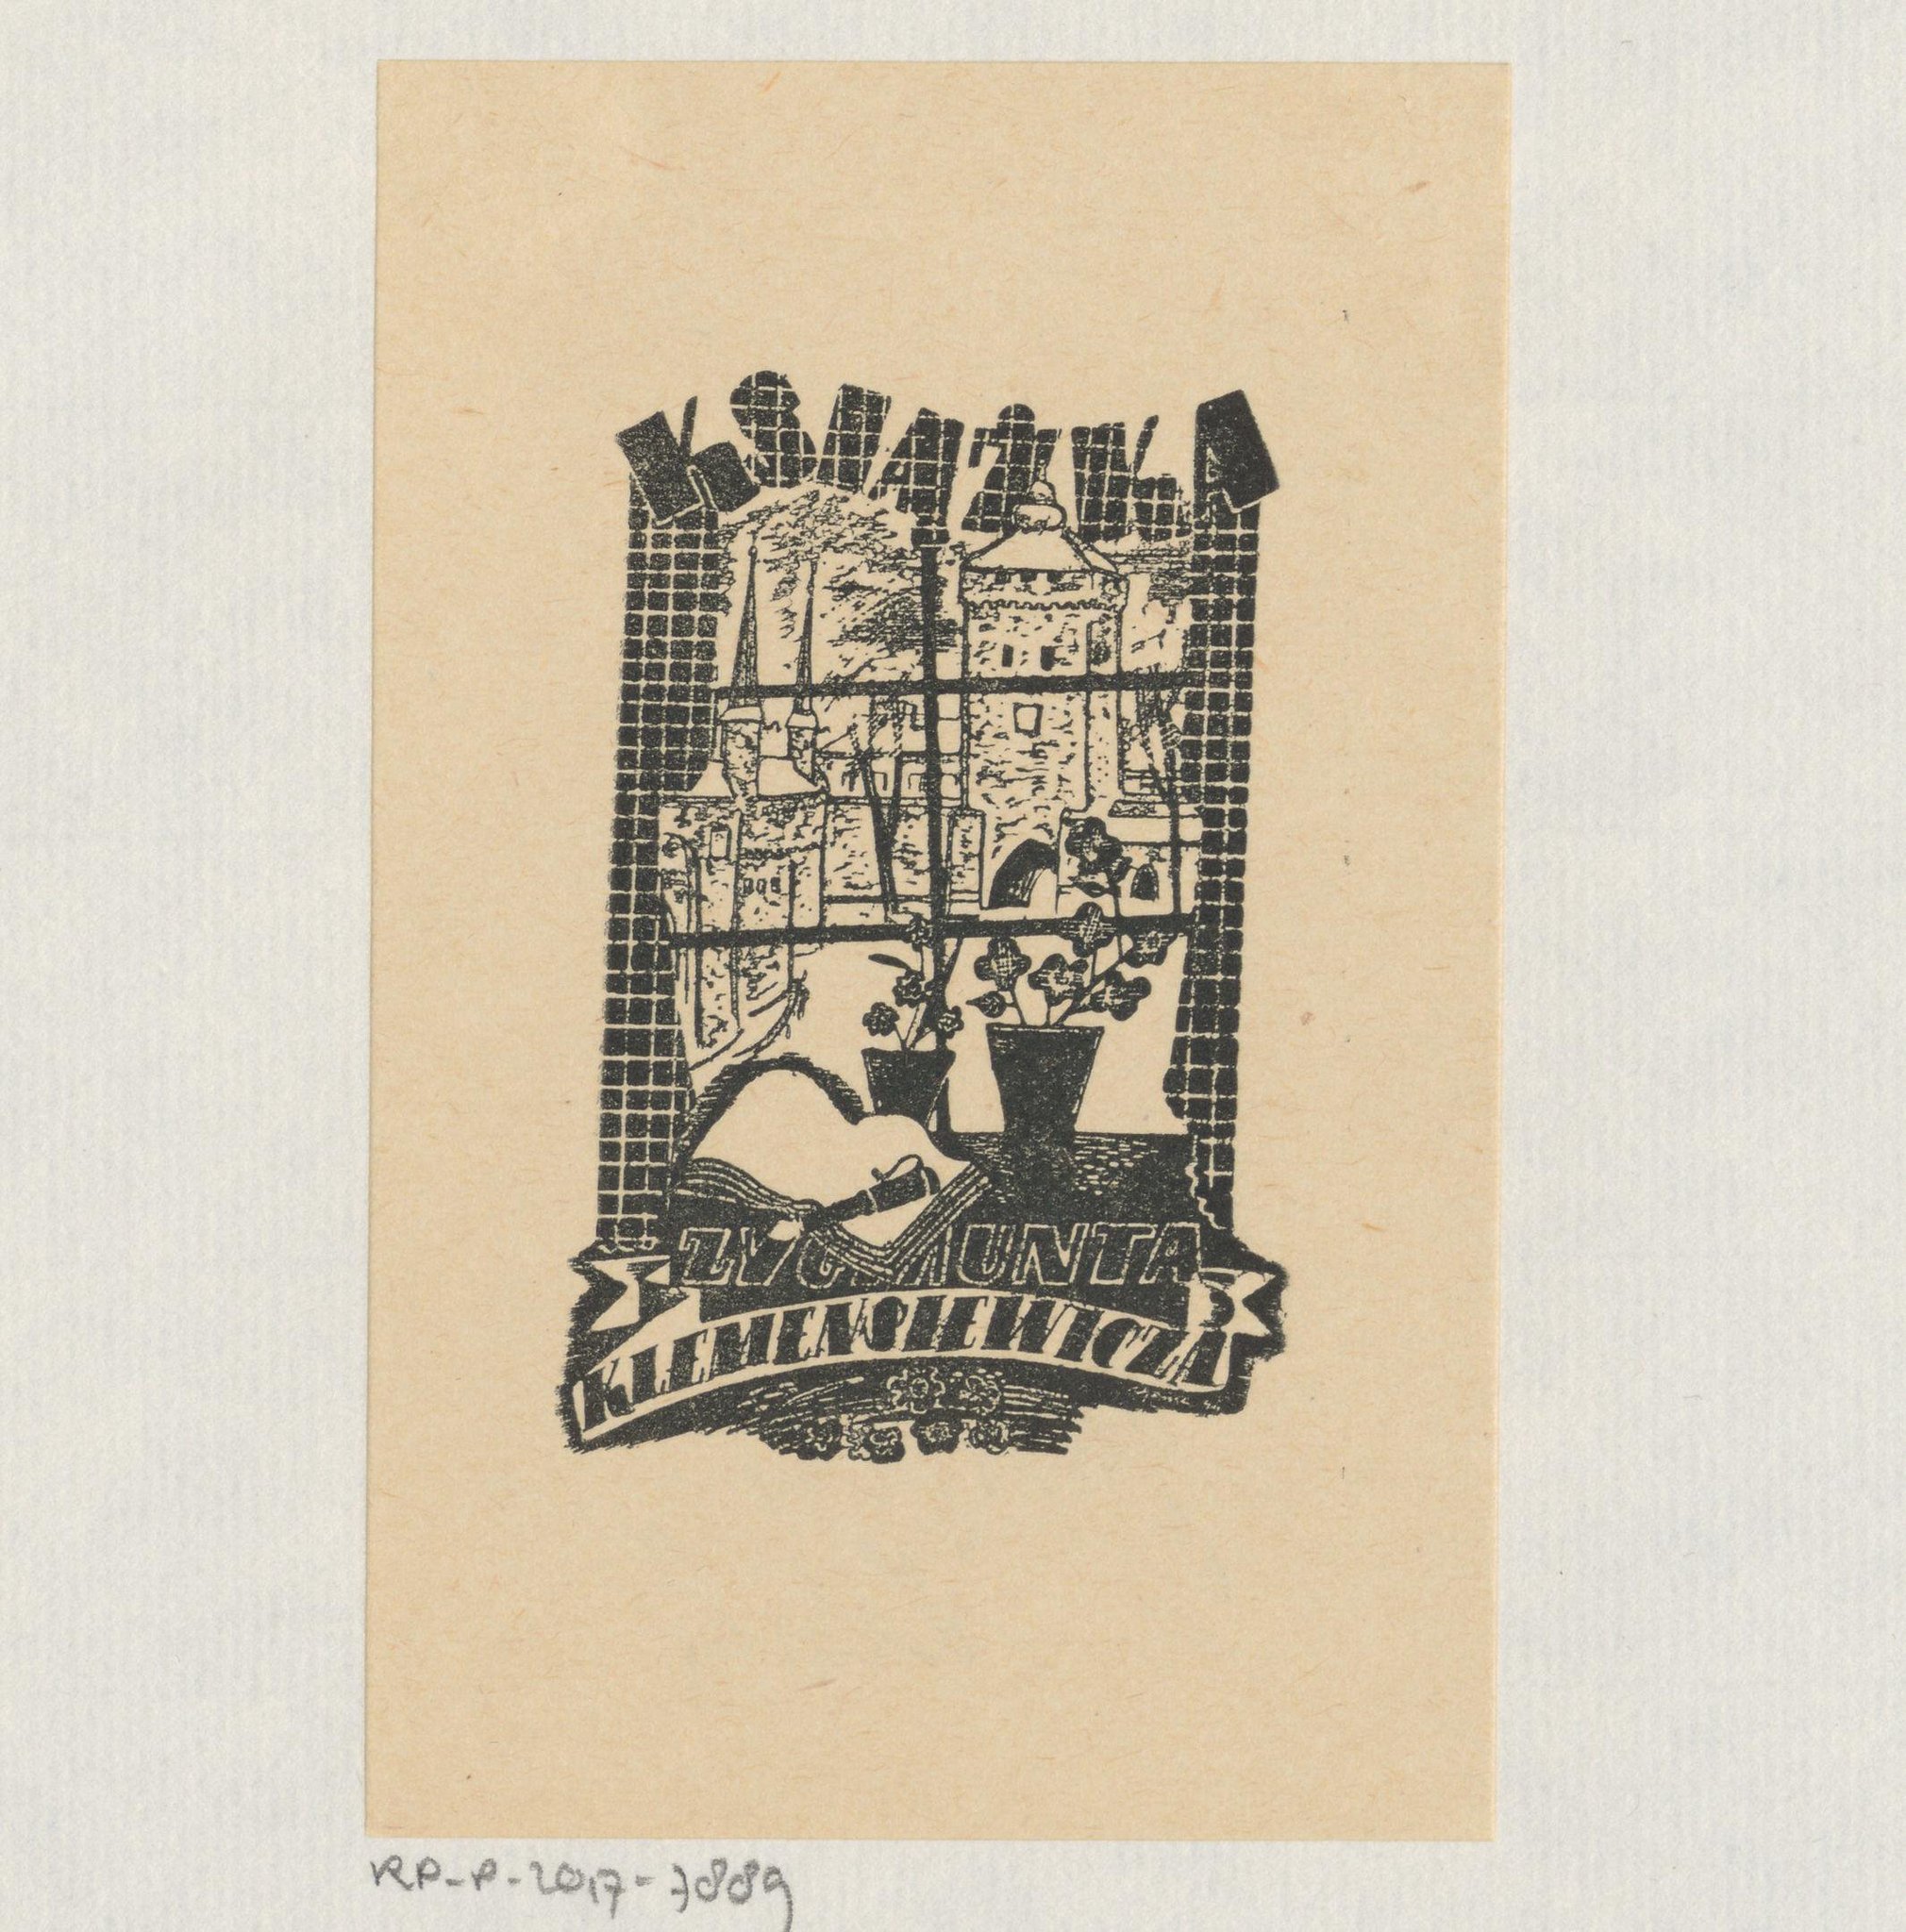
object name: bookplate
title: Ex libris van Zygmunt Klemensiewicz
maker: Anonymous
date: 1922-1946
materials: paper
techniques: printing block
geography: poland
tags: politician, tower, clock tower ~ monumental adornment, view through a window, book